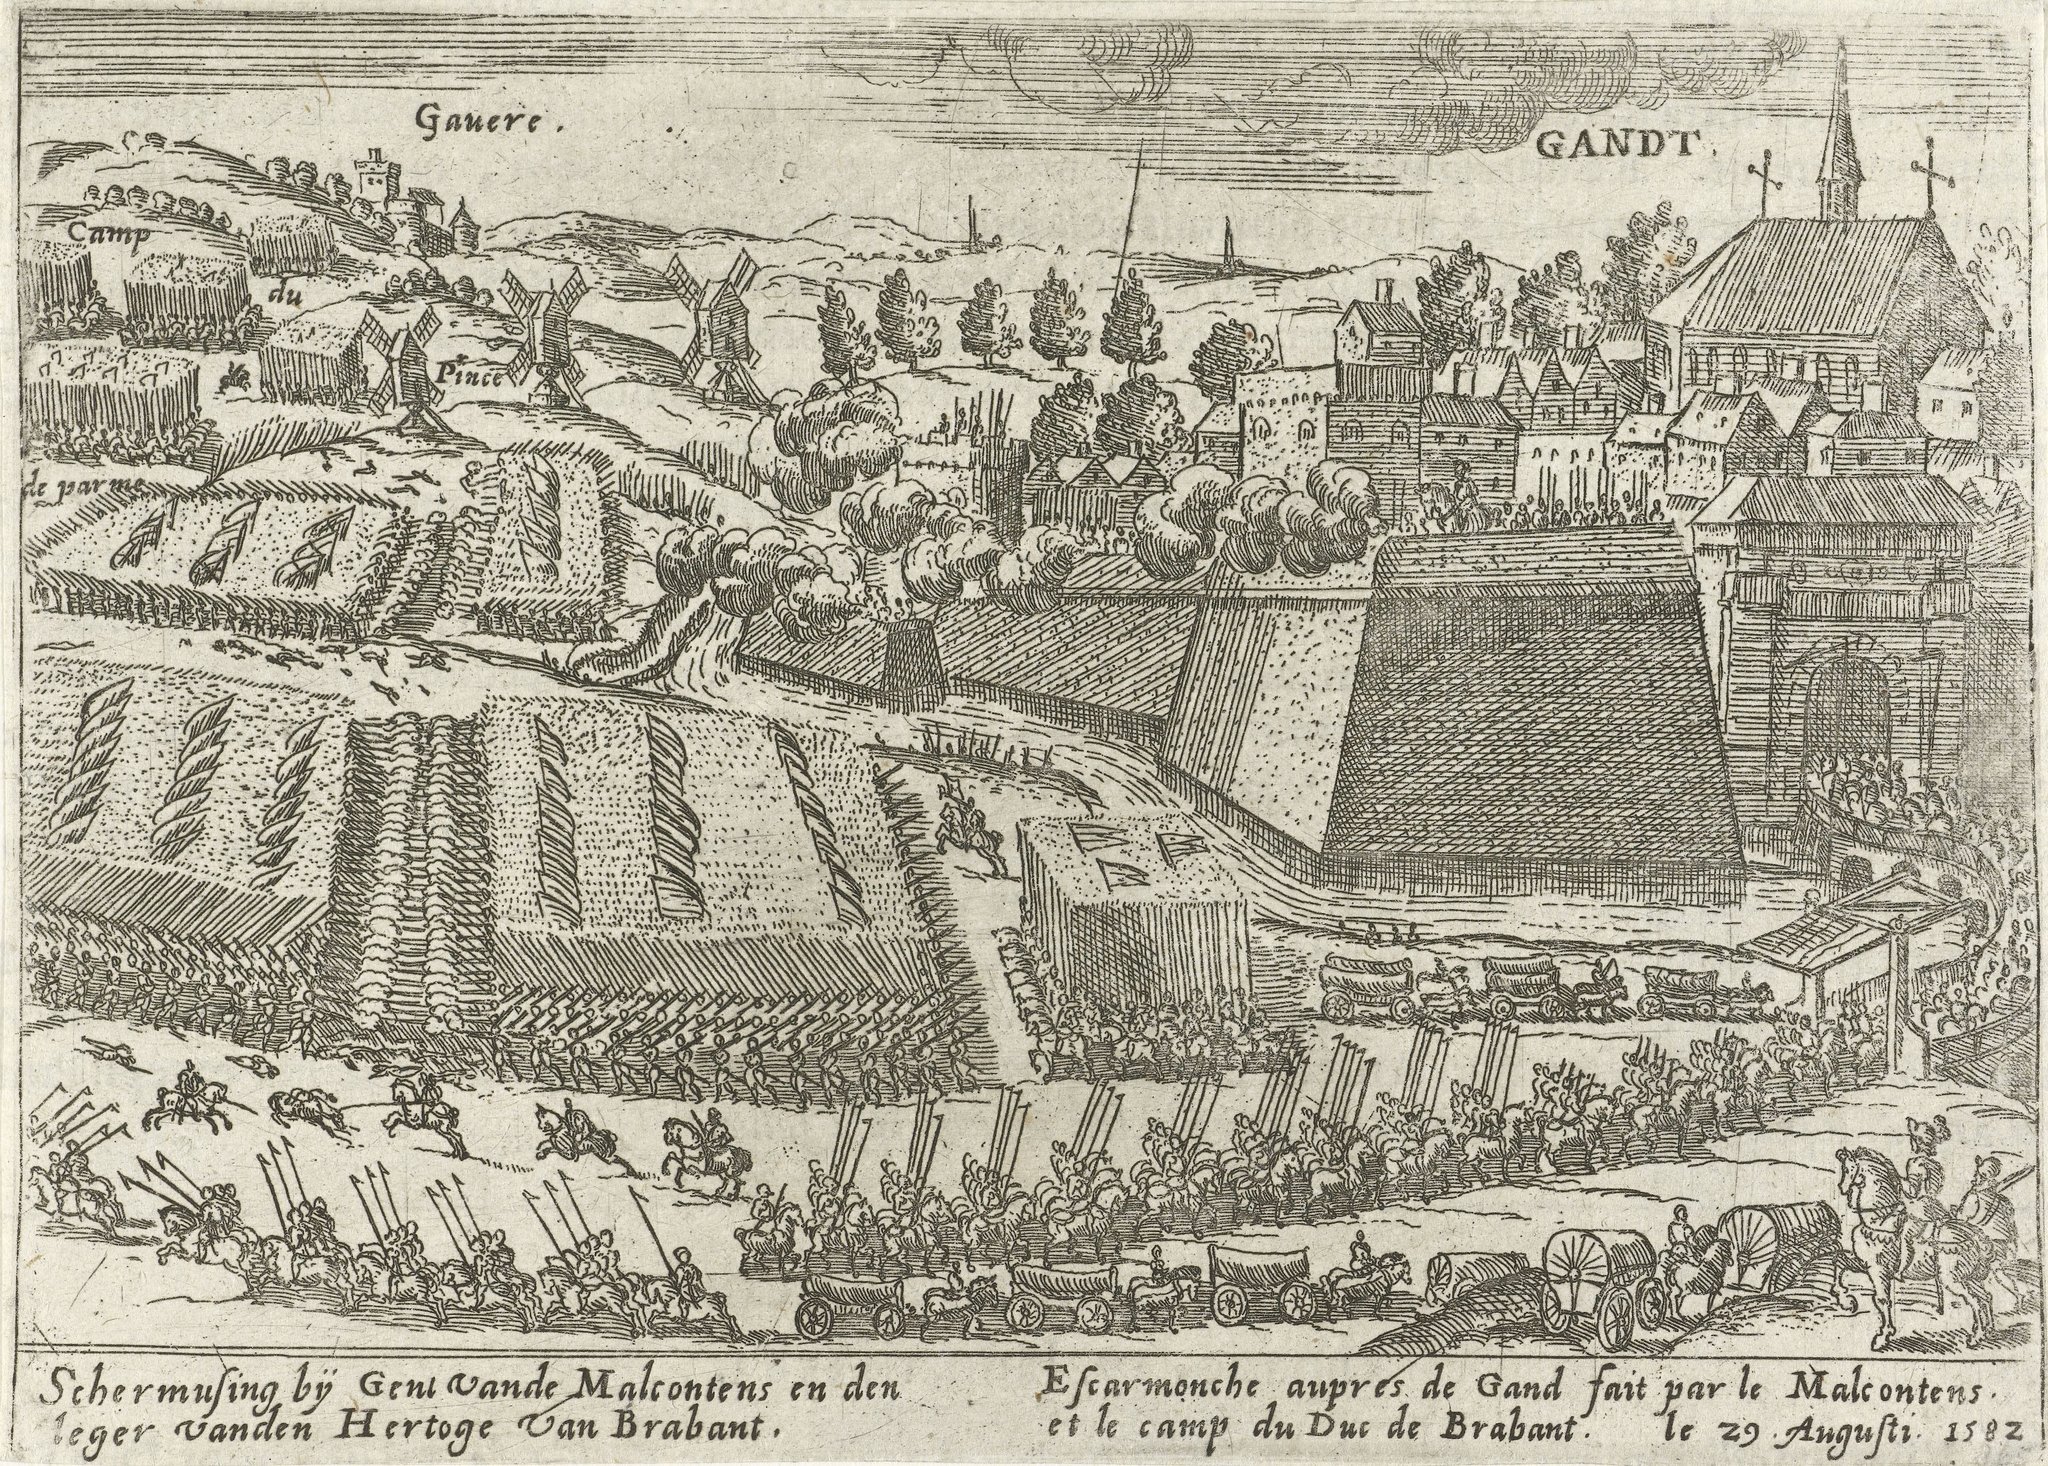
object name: history print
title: Schermutseling bij Gent, 1582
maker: Anonymous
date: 1613-1615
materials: paper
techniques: etching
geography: northern netherlands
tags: paris, françois-hercule de valois (hertog van anjou), battle, ghent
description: Schermutselingen tussen de legers van de hertog van Anjou en de Malcontenten bij Gent en Grave, 27 of 29 augustus 1582. Met onderschrift van 2 regels in het Nederlands en 2 regels in het Frans. Ongenummerd. Bedrukt op achterzijde met tekst in het Latijn.